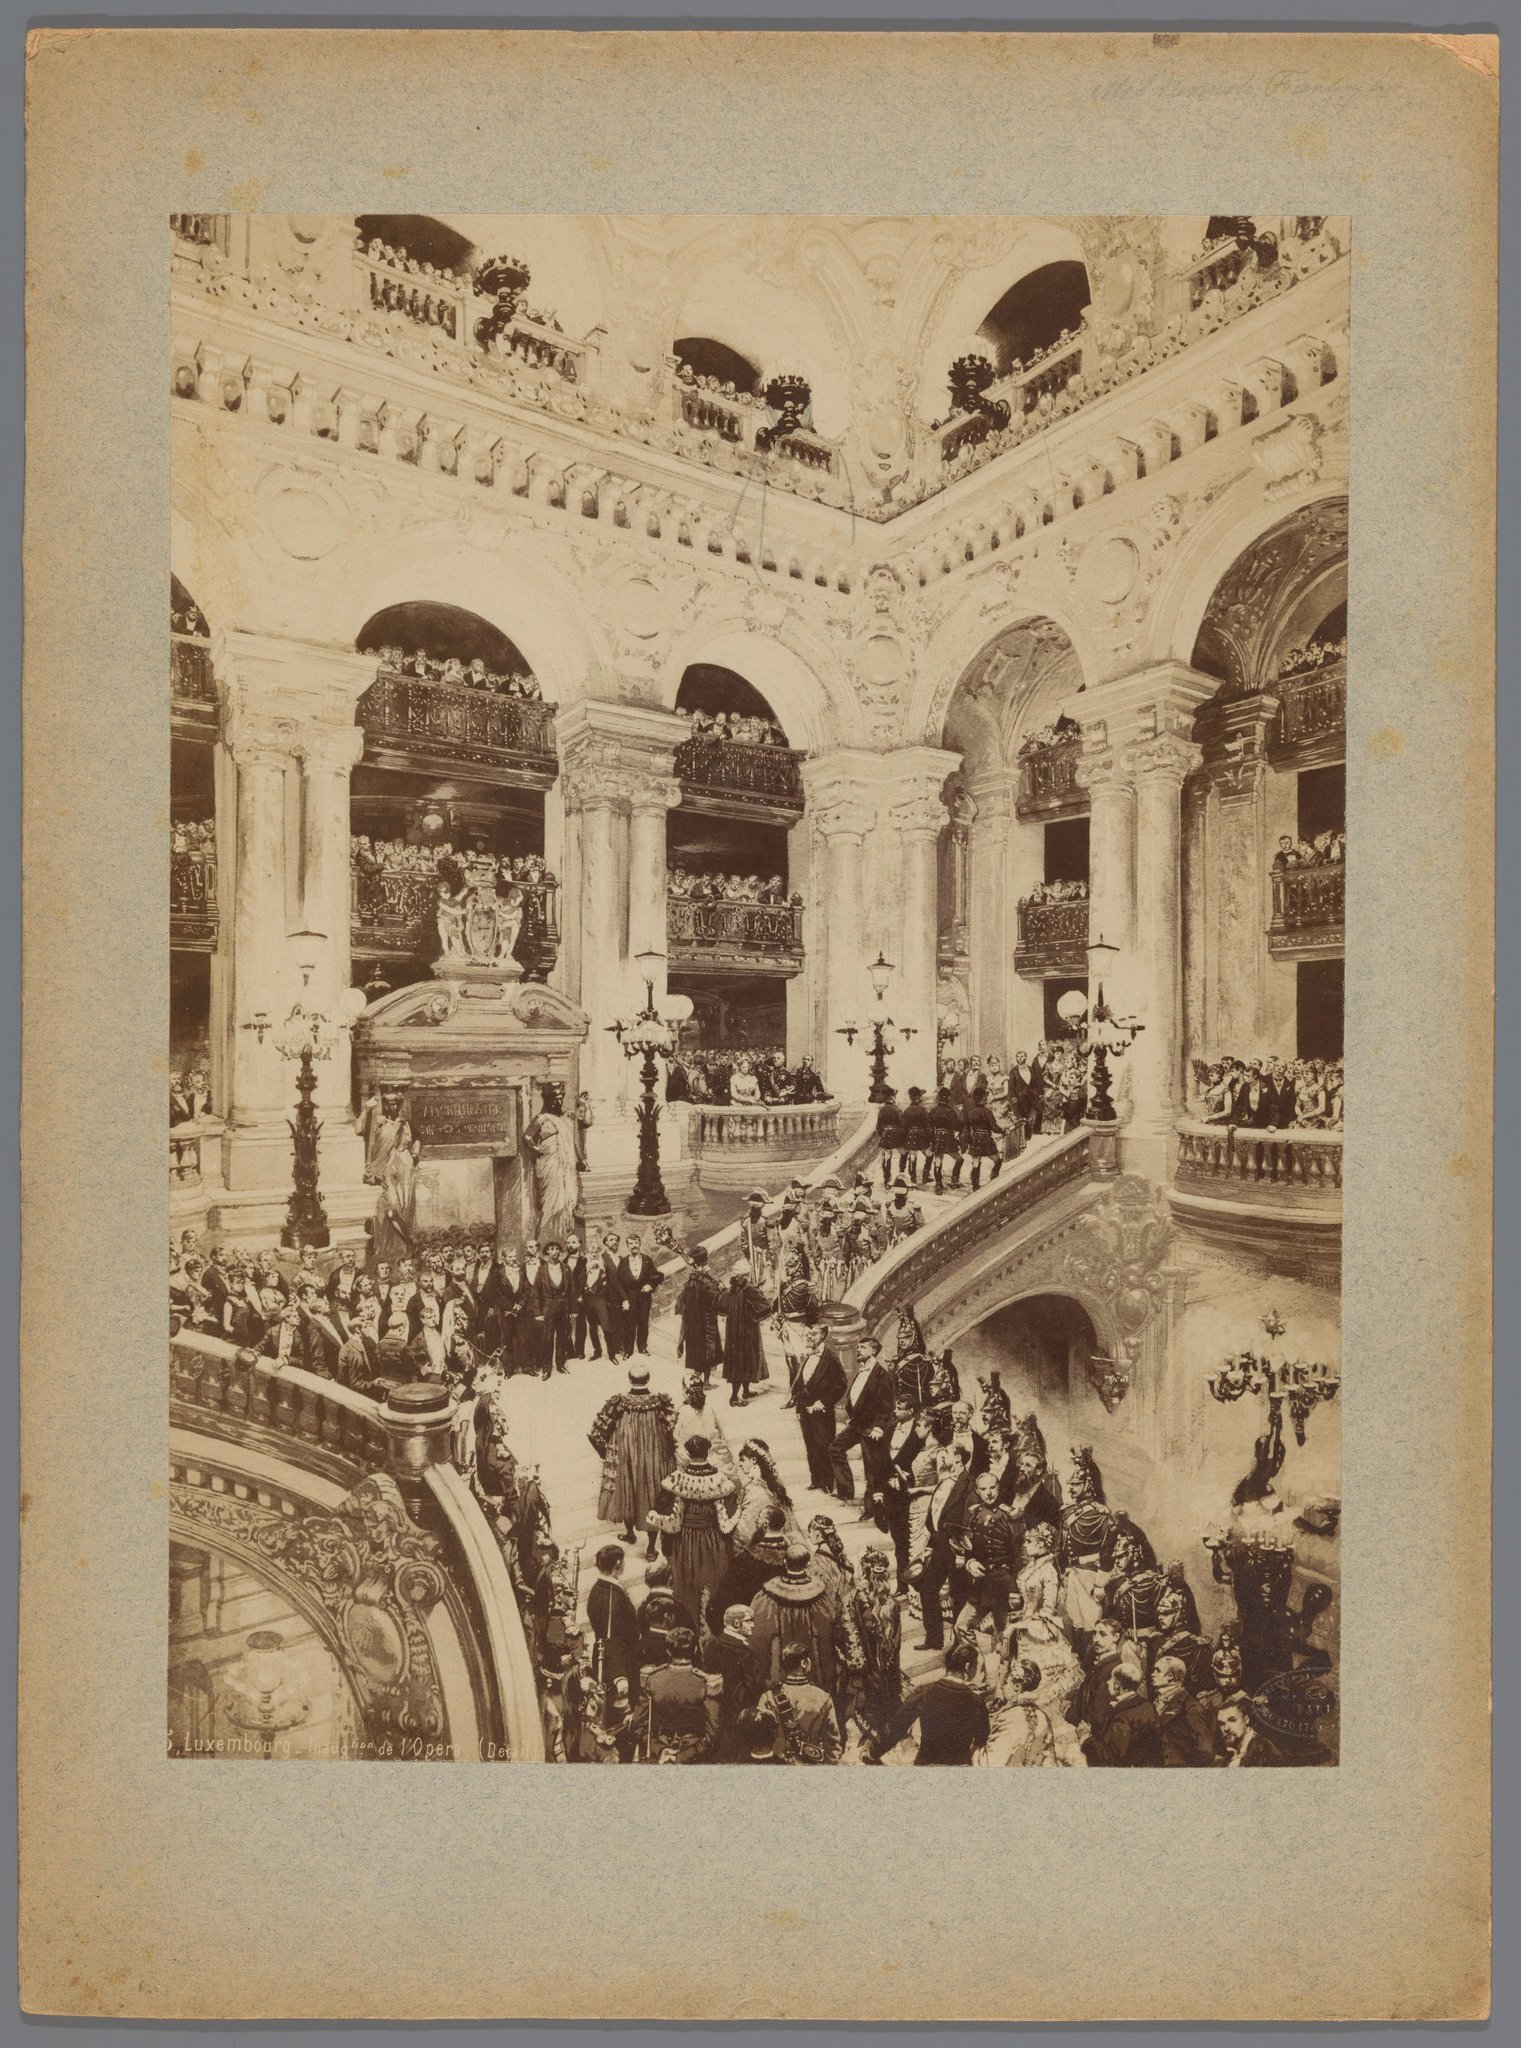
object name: photograph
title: Fotoreproductie van een schilderij door Édouard Detaille, getiteld 'Inauguration de l'Opéra'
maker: j. kuhn (fotograaf)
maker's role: fotograaf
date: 1875-1900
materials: cardboard, photographic support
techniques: albumen print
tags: staircase, picture, painting, opera house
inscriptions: inscription: ‘5, Luxembourg .’, name: ‘Photographic Company J. KUHN PARIS 220 170 174 Rue de Rivoli’